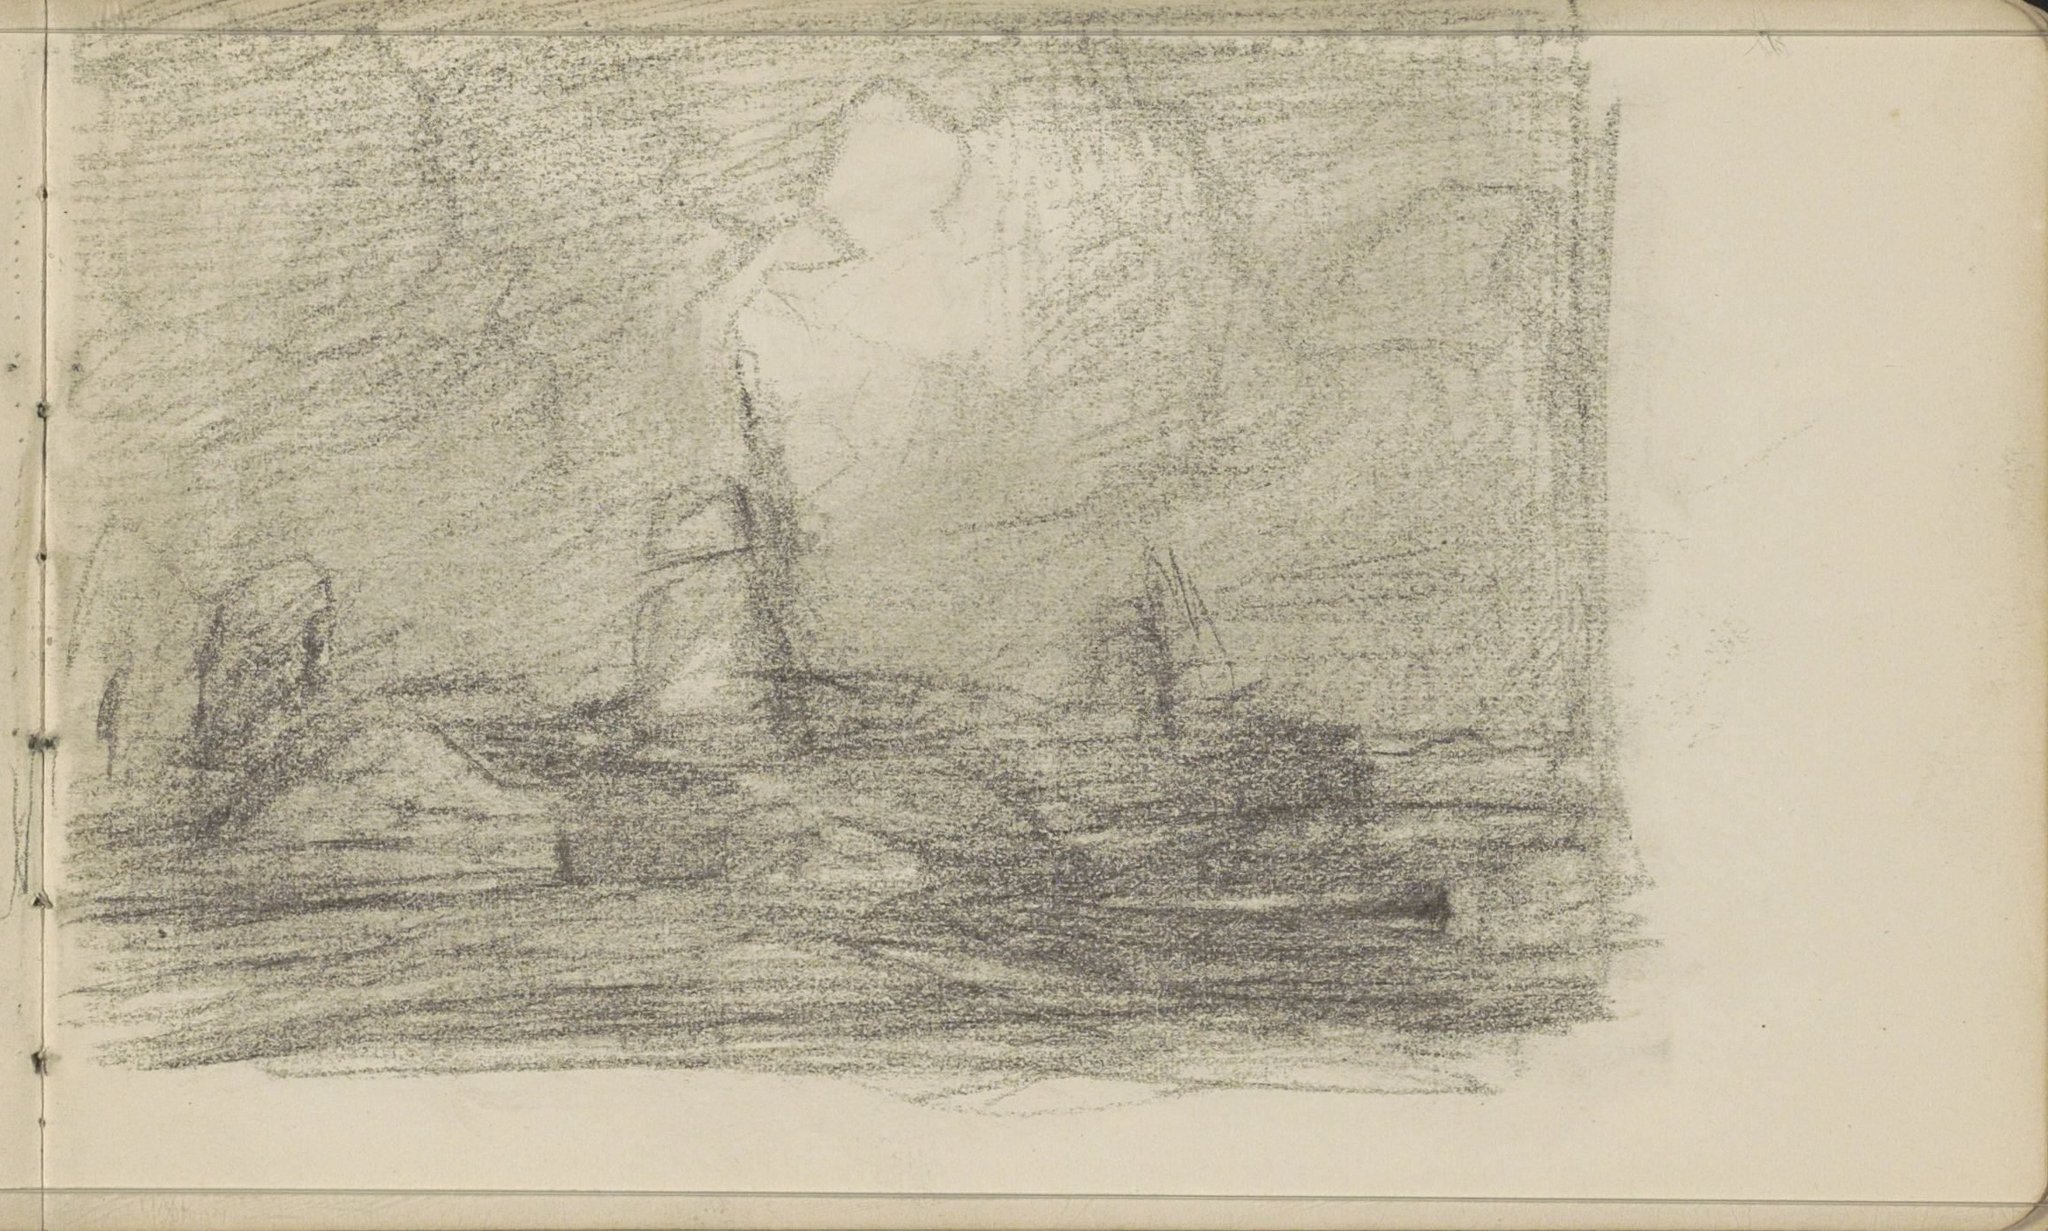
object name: sketchbook leaf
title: Landschap met molens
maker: johan antonie de jonge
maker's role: draughtsman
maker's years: 1864-1927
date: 1881-1927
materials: chalk, paper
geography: south holland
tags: windmill in landscape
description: Landschap met molens. Blad 2 recto uit een schetsboek met 34 bladen.